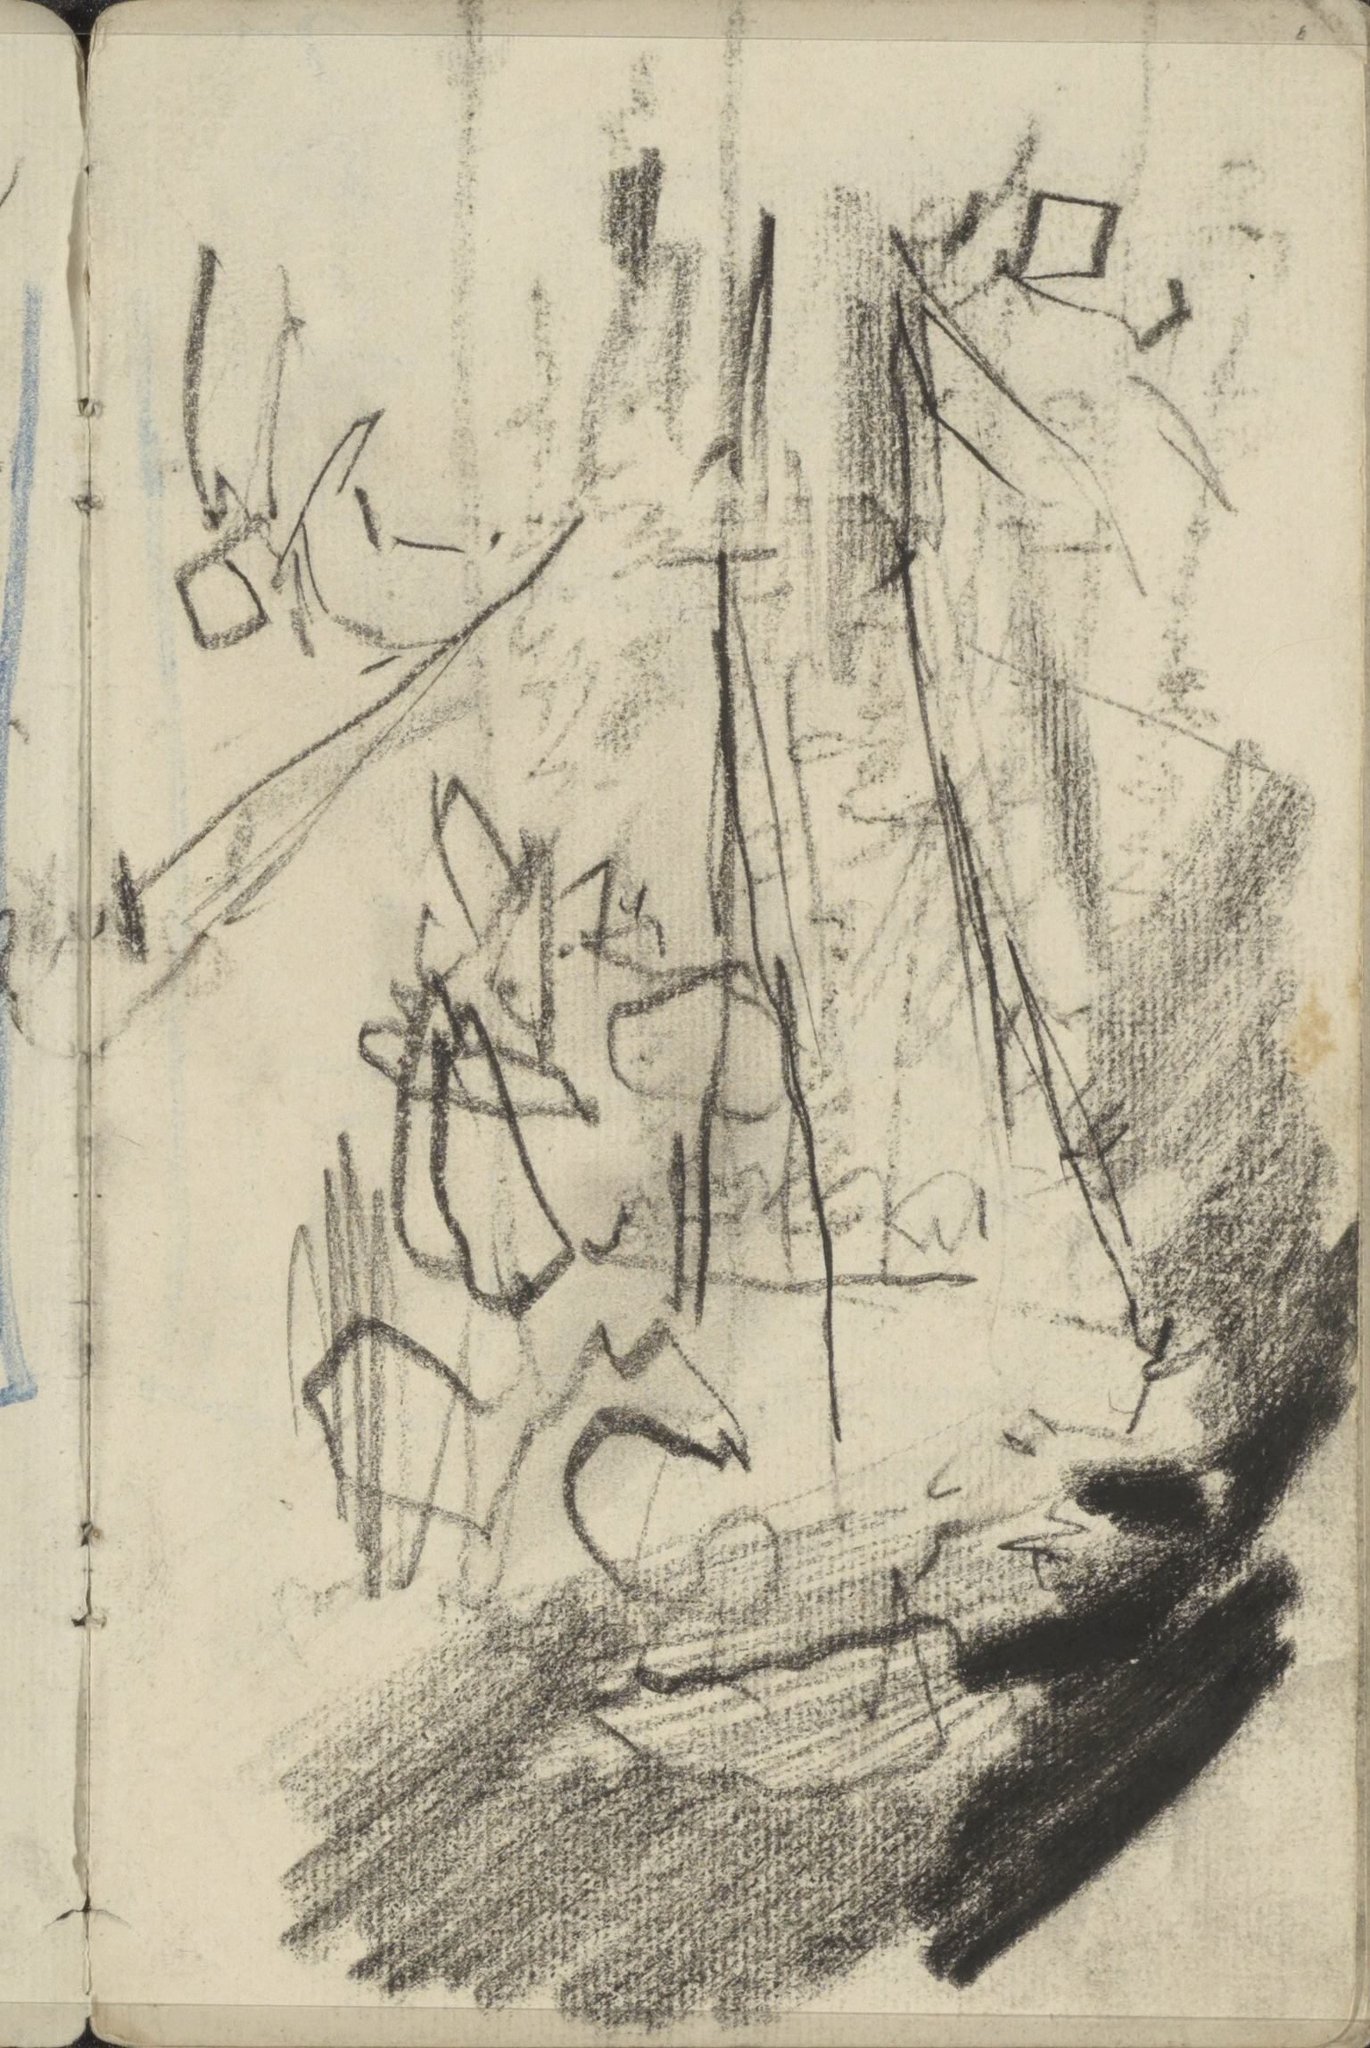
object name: sketchbook leaf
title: Studieblad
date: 1883-1885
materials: chalk, paper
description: Pagina 6 uit een schetsboek met 16 bladen.